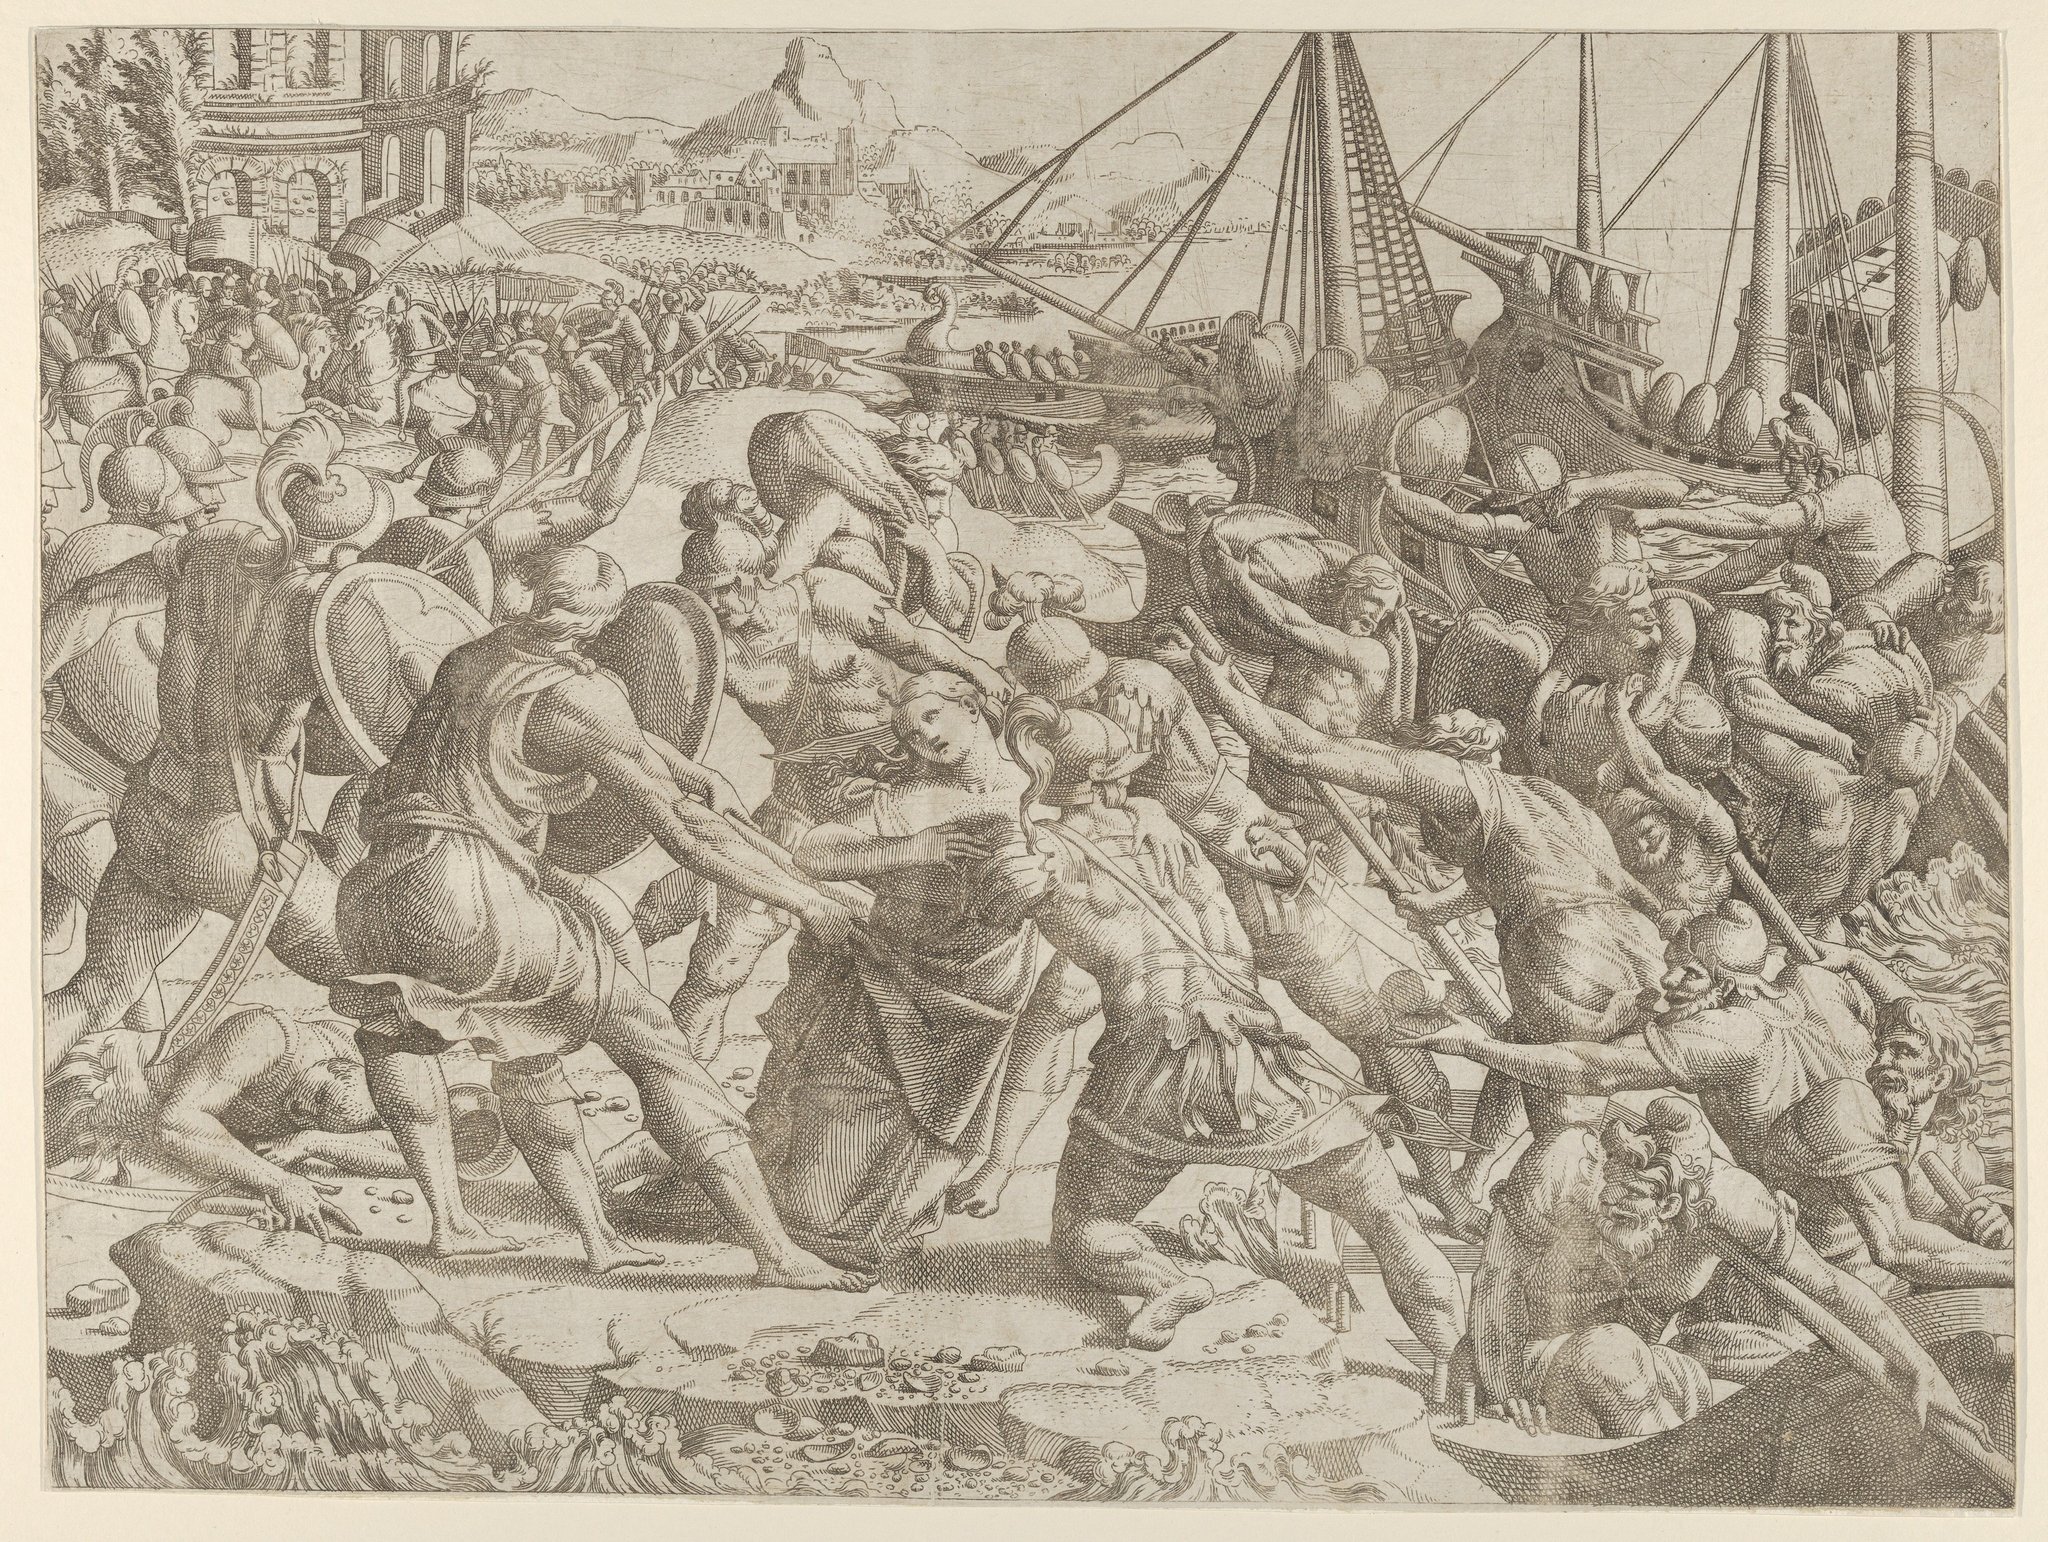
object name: print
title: The Abduction of Helen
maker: jean mignon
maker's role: artist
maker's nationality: french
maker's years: 1535-1555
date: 1535-1555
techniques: etching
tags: bow and arrow,shields,men,helen,crowd